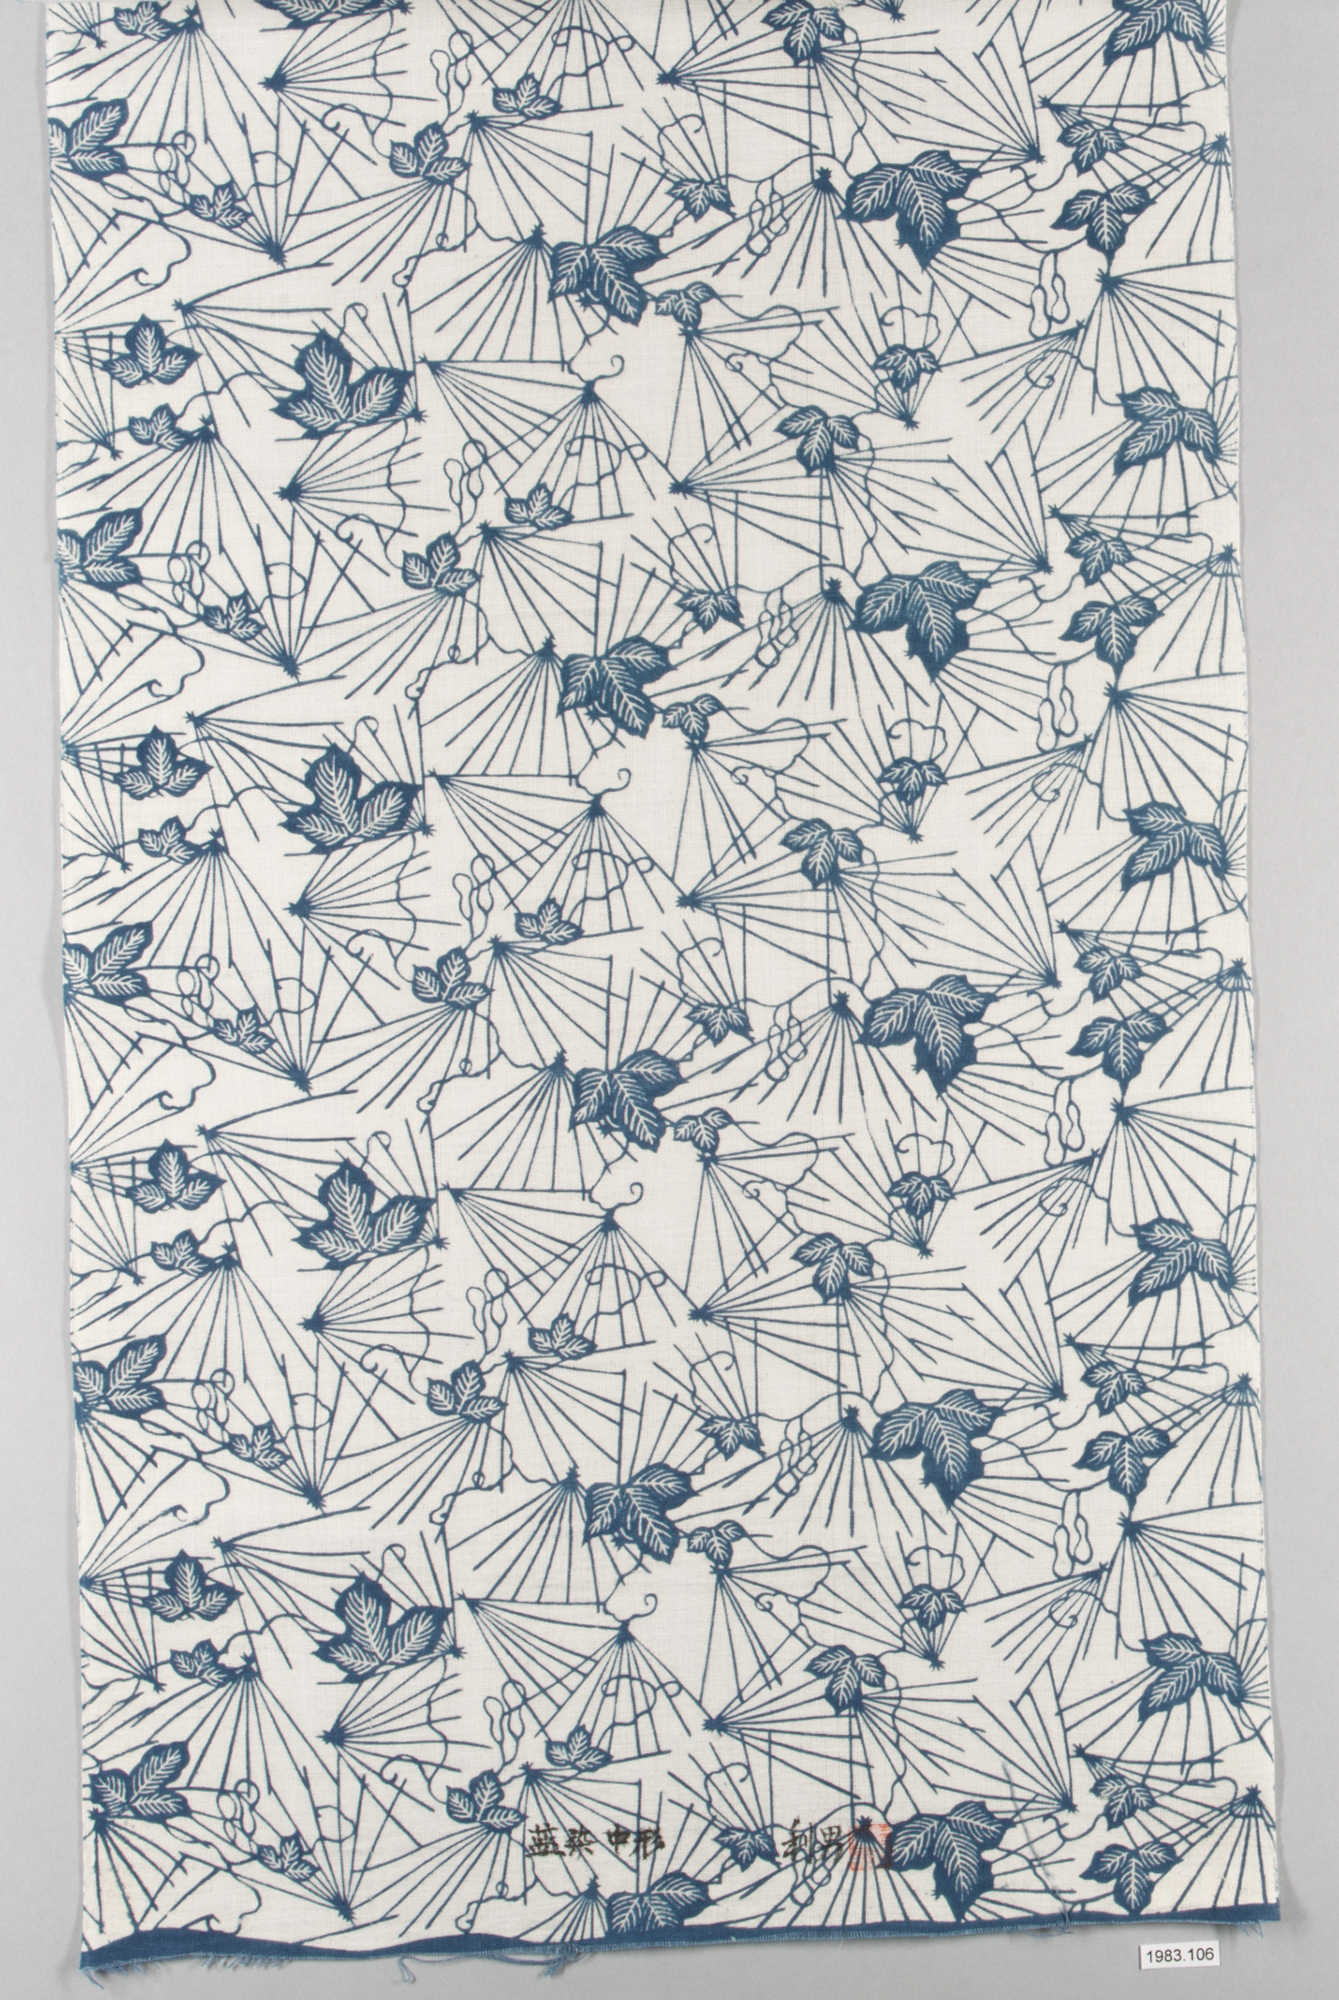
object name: length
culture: japanese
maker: toshio matsubara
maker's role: artist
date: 1901-2000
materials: cotton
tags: leaves,vines